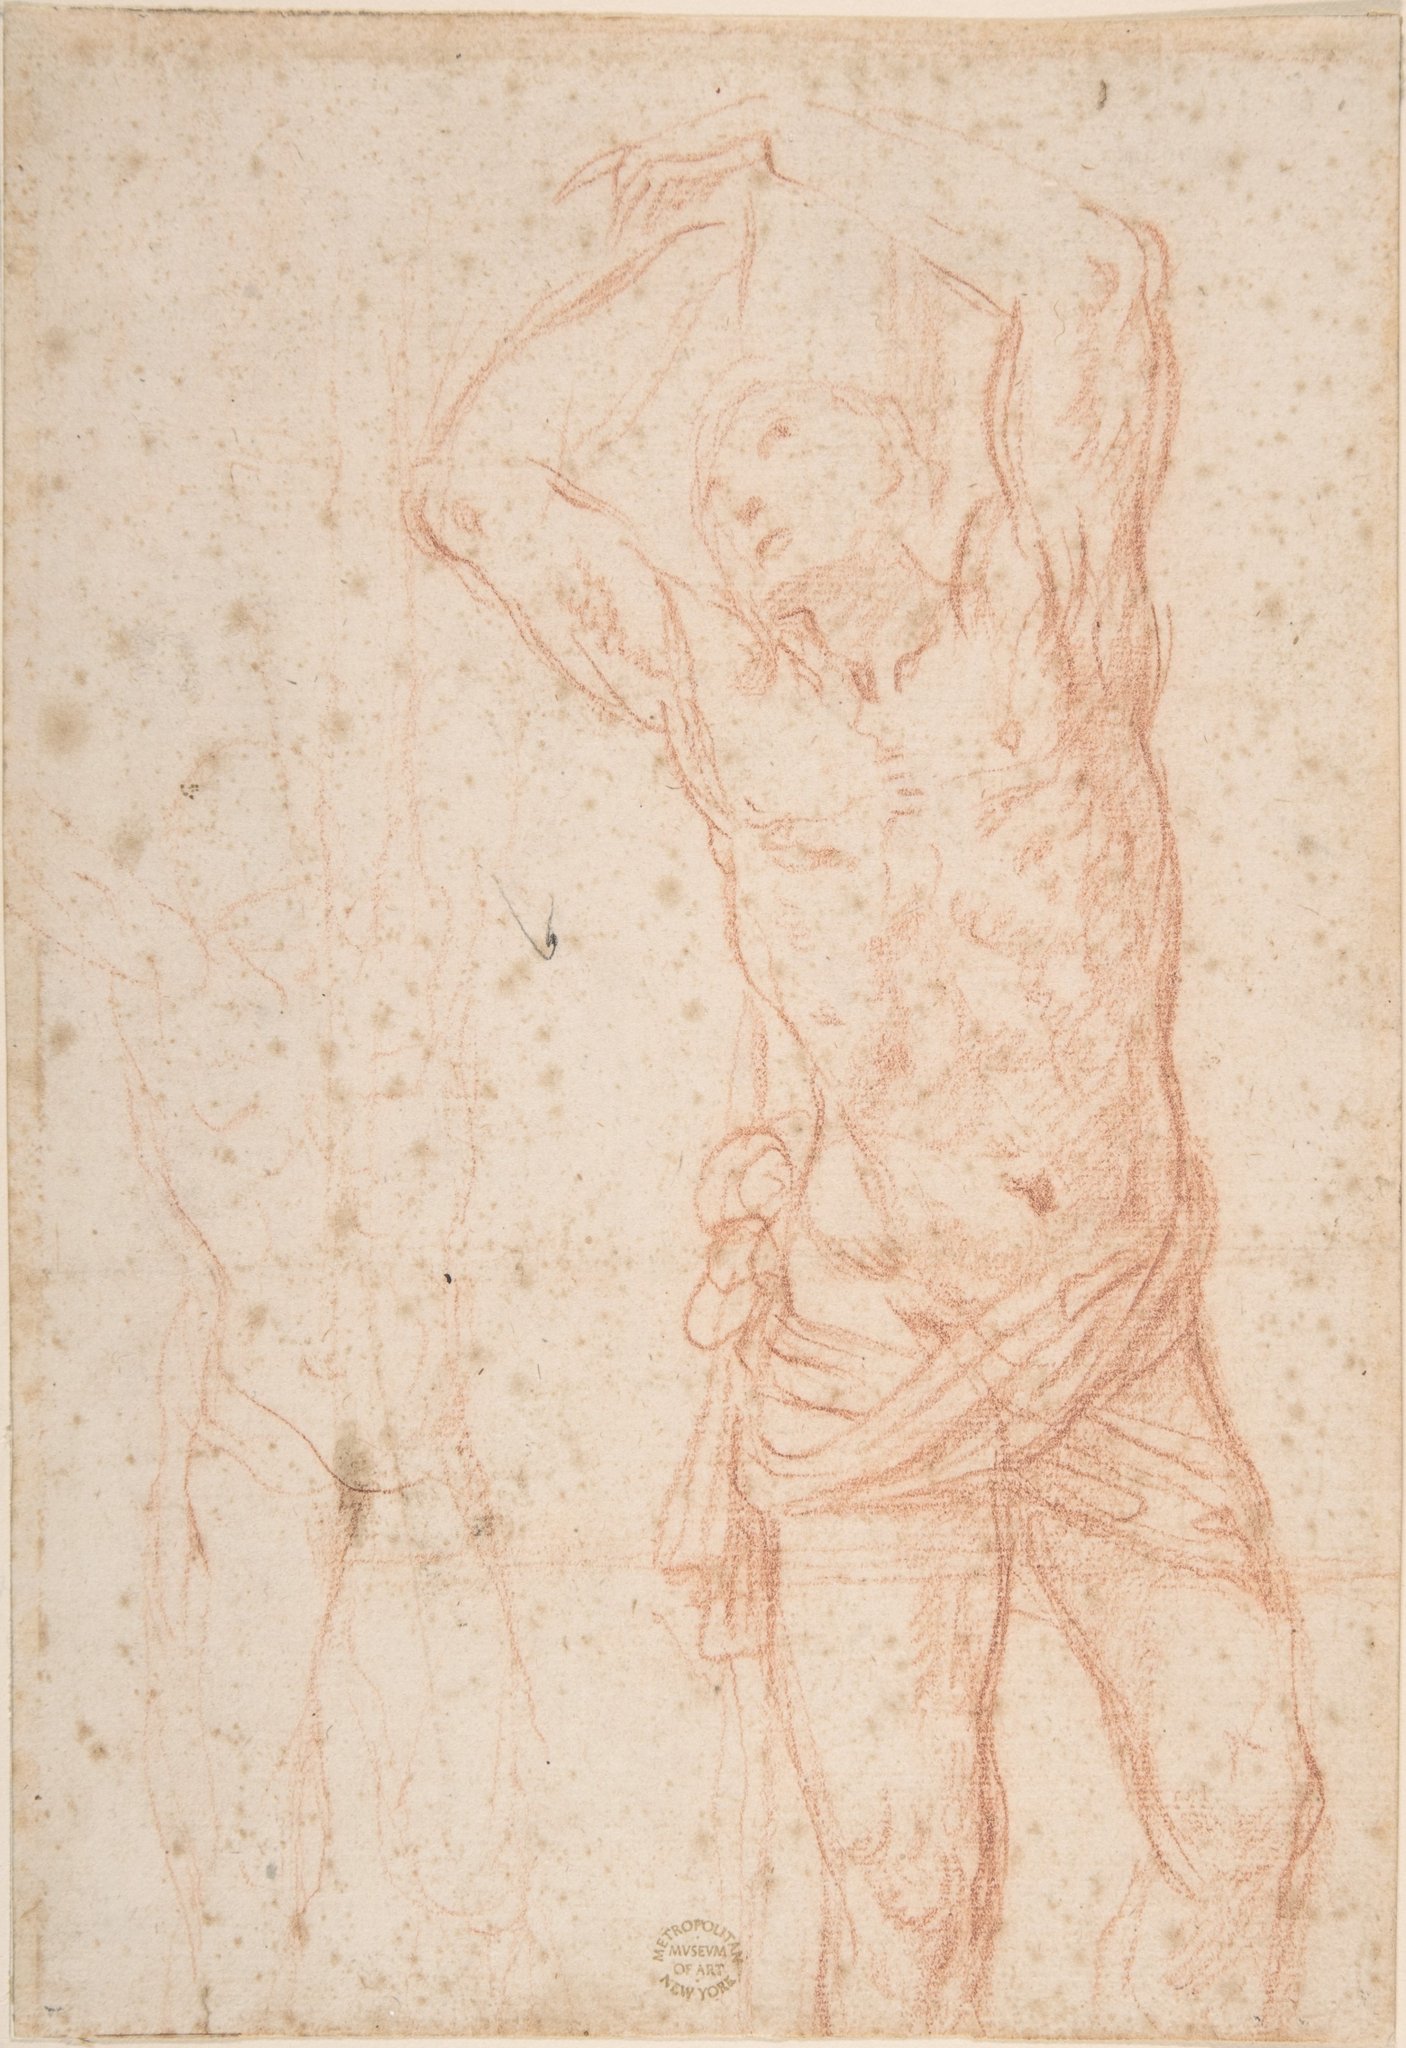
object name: drawing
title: Saint Sebastian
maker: anonymous, italian, roman-bolognese, 17th century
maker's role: artist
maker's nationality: italian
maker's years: 1600-1700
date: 1601-1700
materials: chalk, paper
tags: men,saints